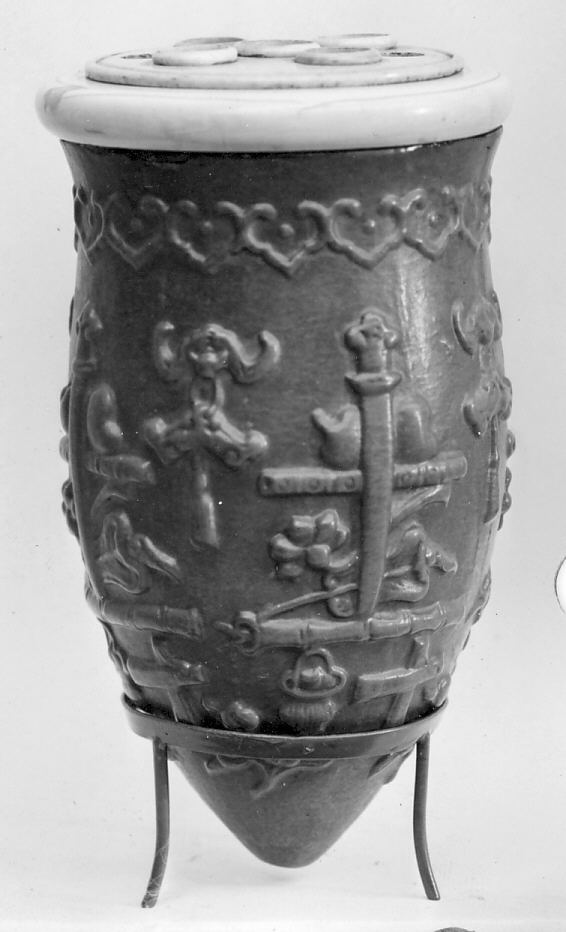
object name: cricket cage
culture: chinese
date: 1701-1900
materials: ivory